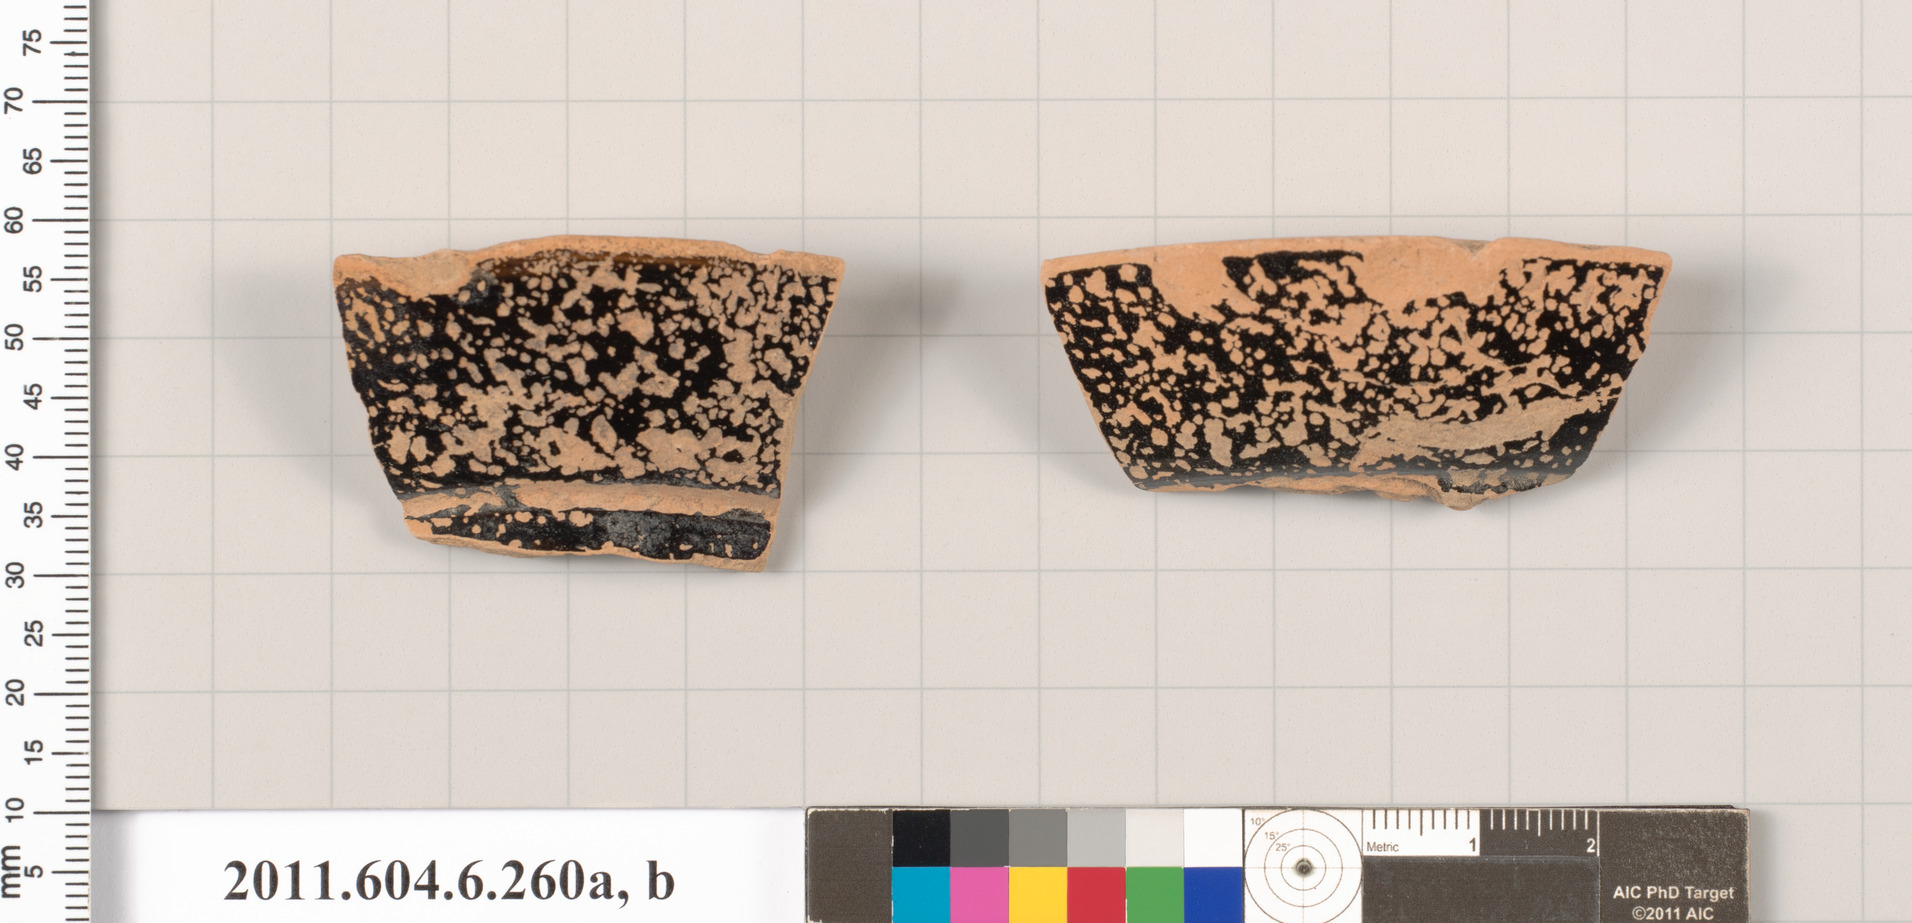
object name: amphora fragment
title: Terracotta fragments of an amphora (jar)?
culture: greek, attic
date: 600-401 BCE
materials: terracotta